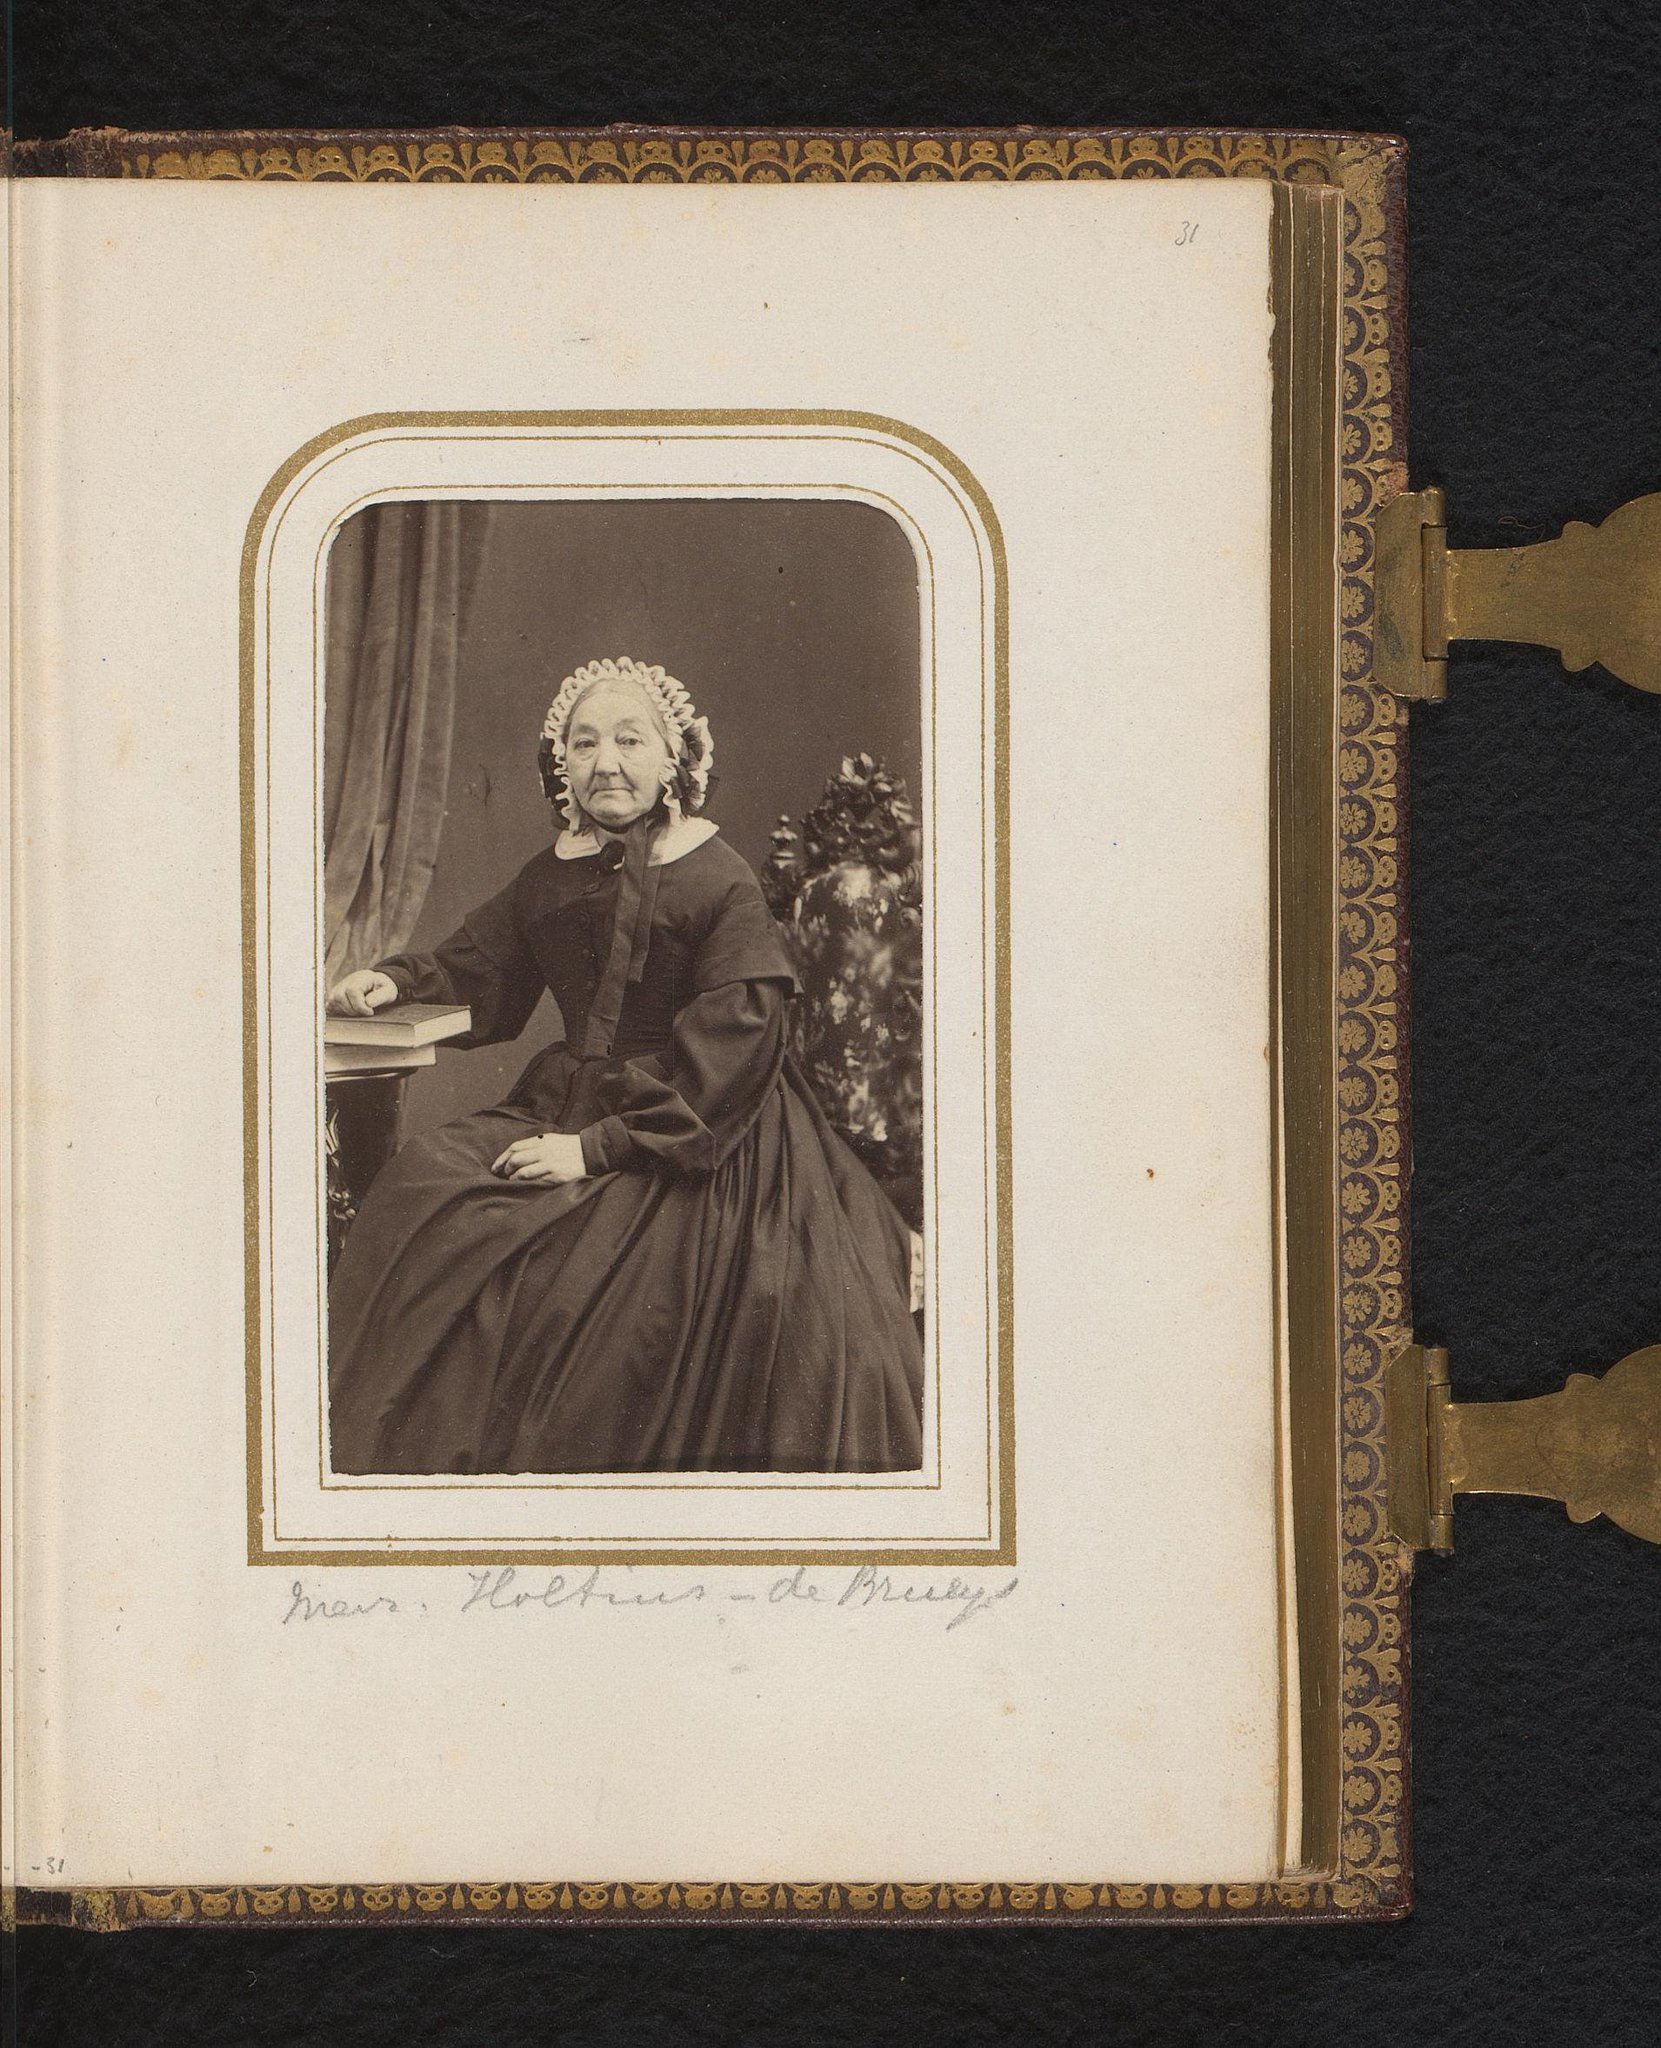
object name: carte de visite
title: Portret van Cecilia Holtius-de Brueys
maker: henri pronk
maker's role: fotograaf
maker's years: 1813-1893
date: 1864-1867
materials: cardboard, paper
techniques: albumen print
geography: the hague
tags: utrecht, historical persons - bb - woman